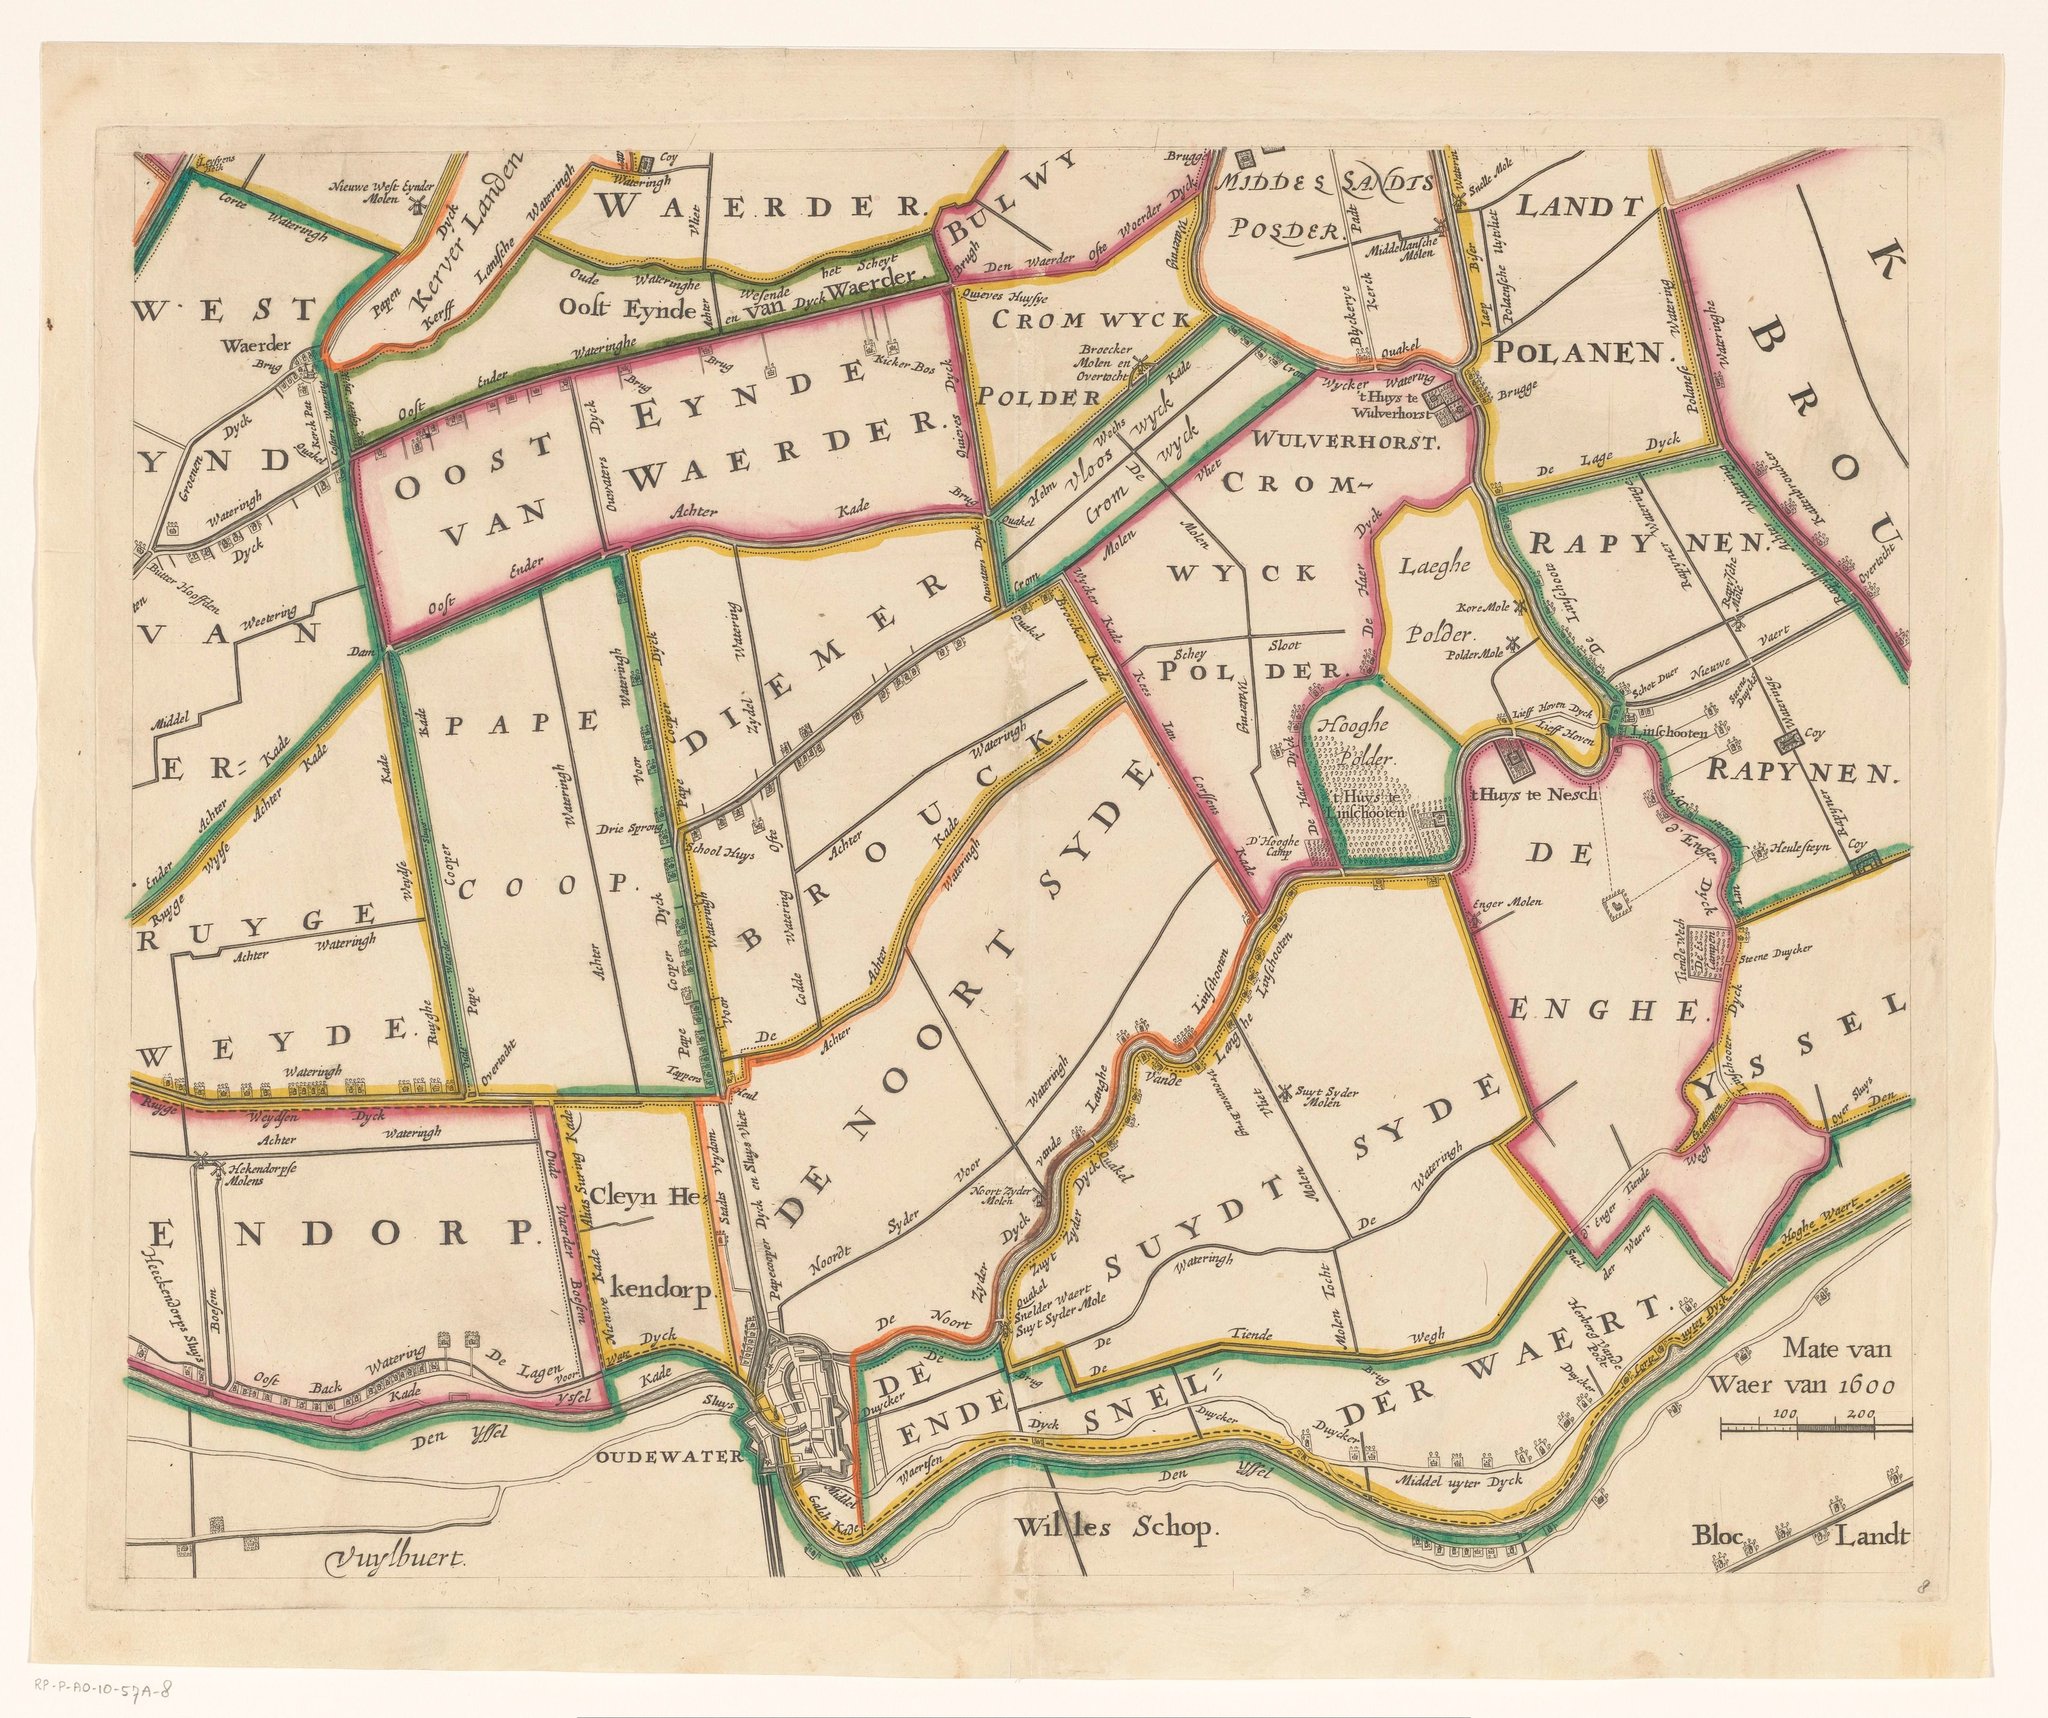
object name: print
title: Kaart van het Hoogheemraadschap van Woerden (achtste deel)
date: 1670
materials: paper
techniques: engraving, hand coloring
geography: amsterdam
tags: maps of separate countries or regions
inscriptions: collector's mark: Lugt 2228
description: Achtste deel (onder midden) van een kaart van het Hoogheemraadschap van Woerden.